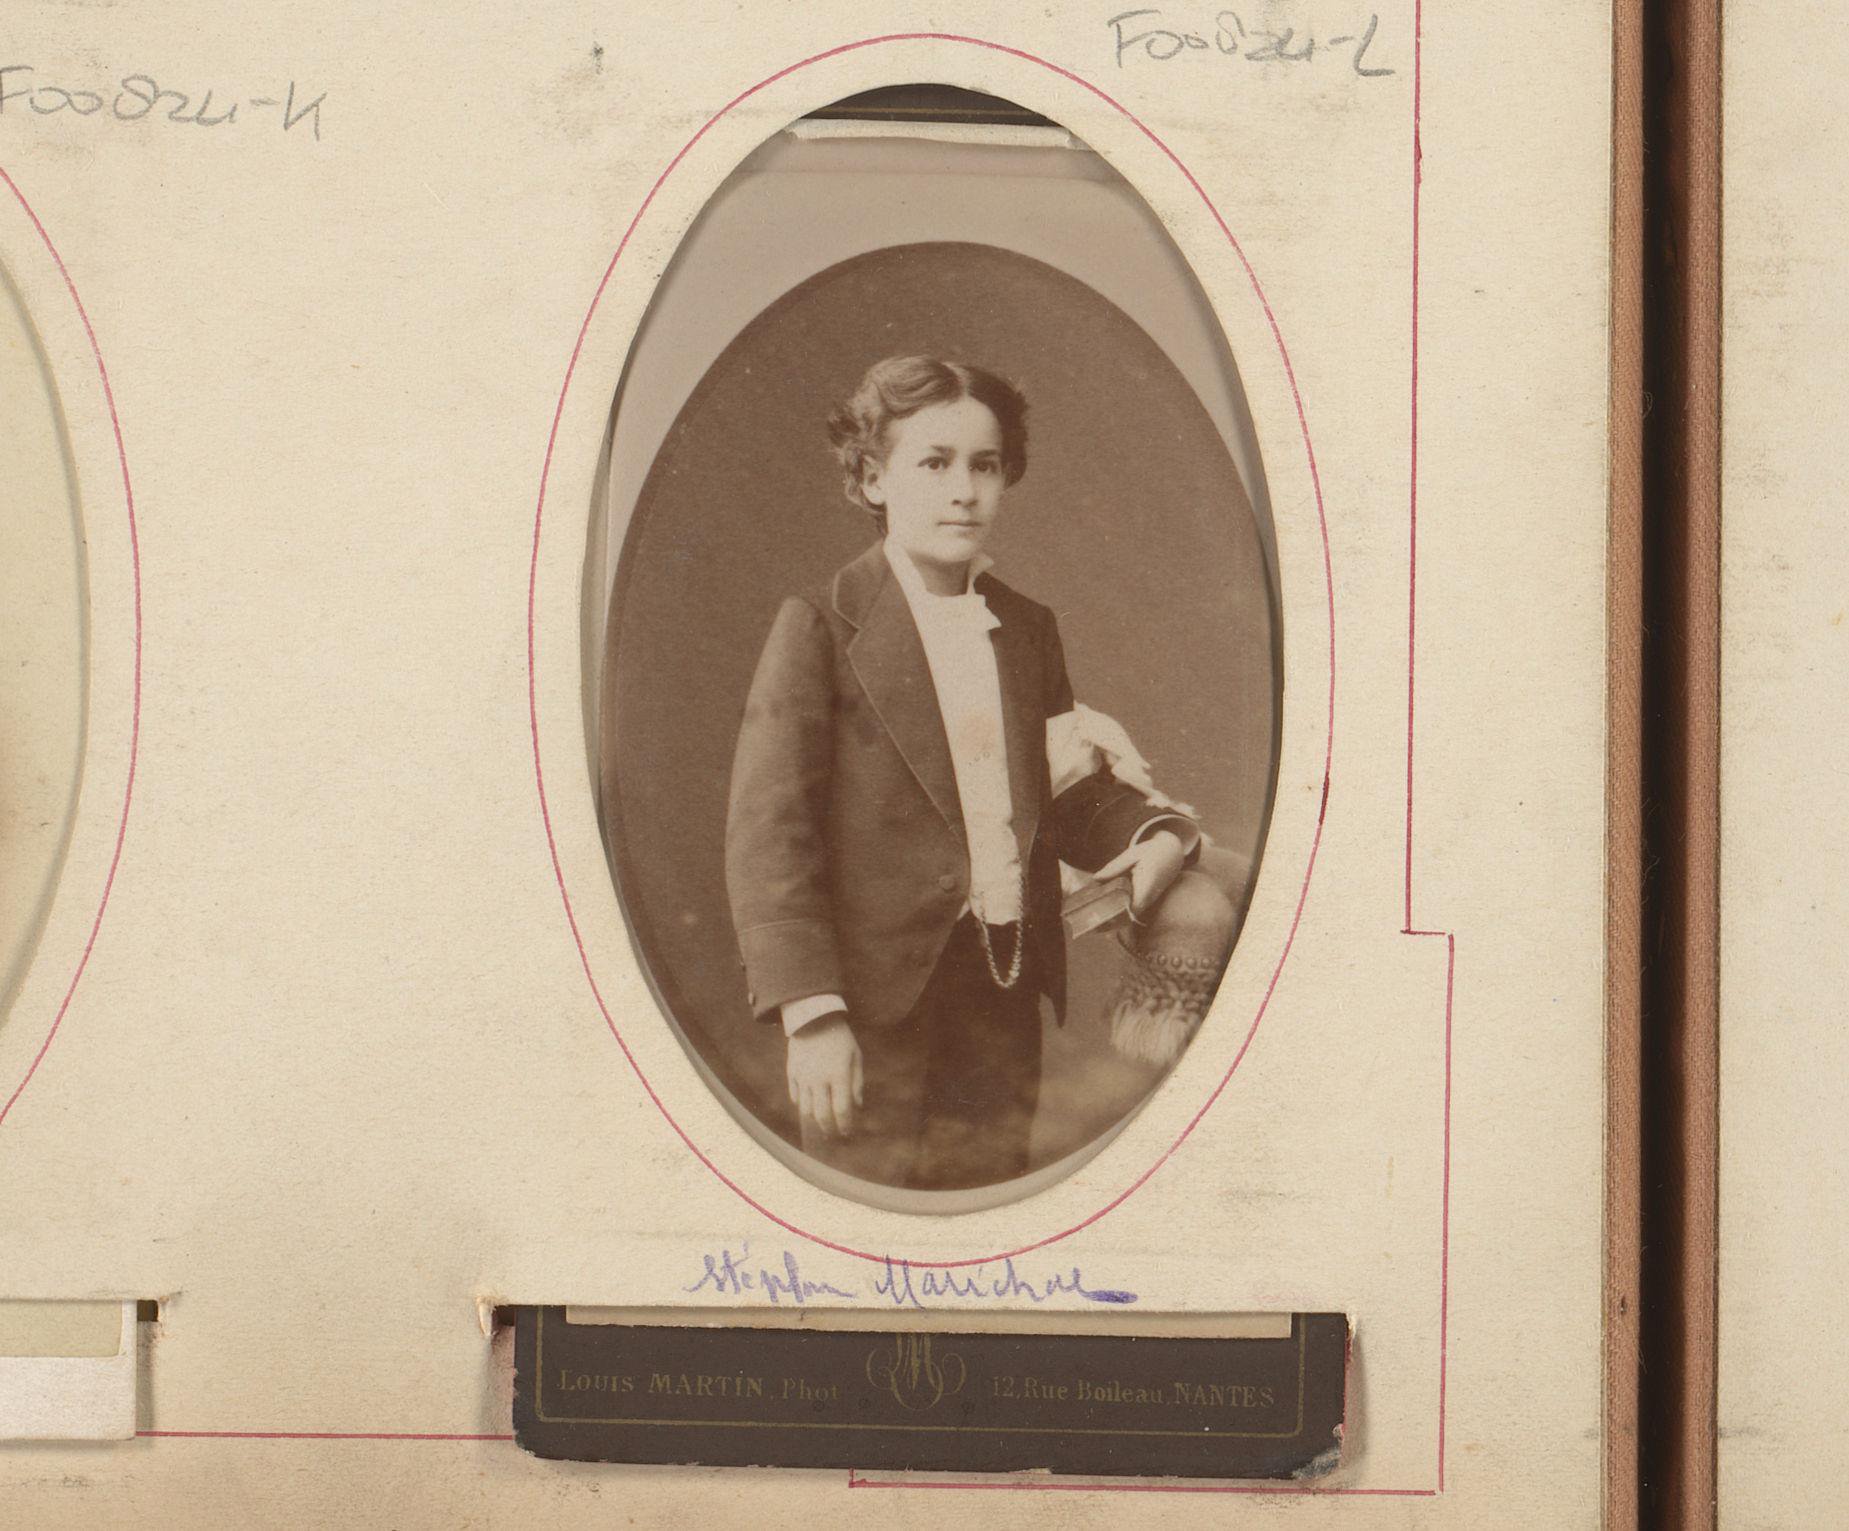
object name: album leaf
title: Portret van Stephan Maréchal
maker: louis martin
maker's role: fotograaf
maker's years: -1925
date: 1870-1890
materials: cardboard, celluloid, paper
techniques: albumen print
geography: nantes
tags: boy (child between toddler and youth), historical persons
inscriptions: inscription: ‘Les Clichés sont conservés’, address: ‘12 Rue Boileau/ NANTES’